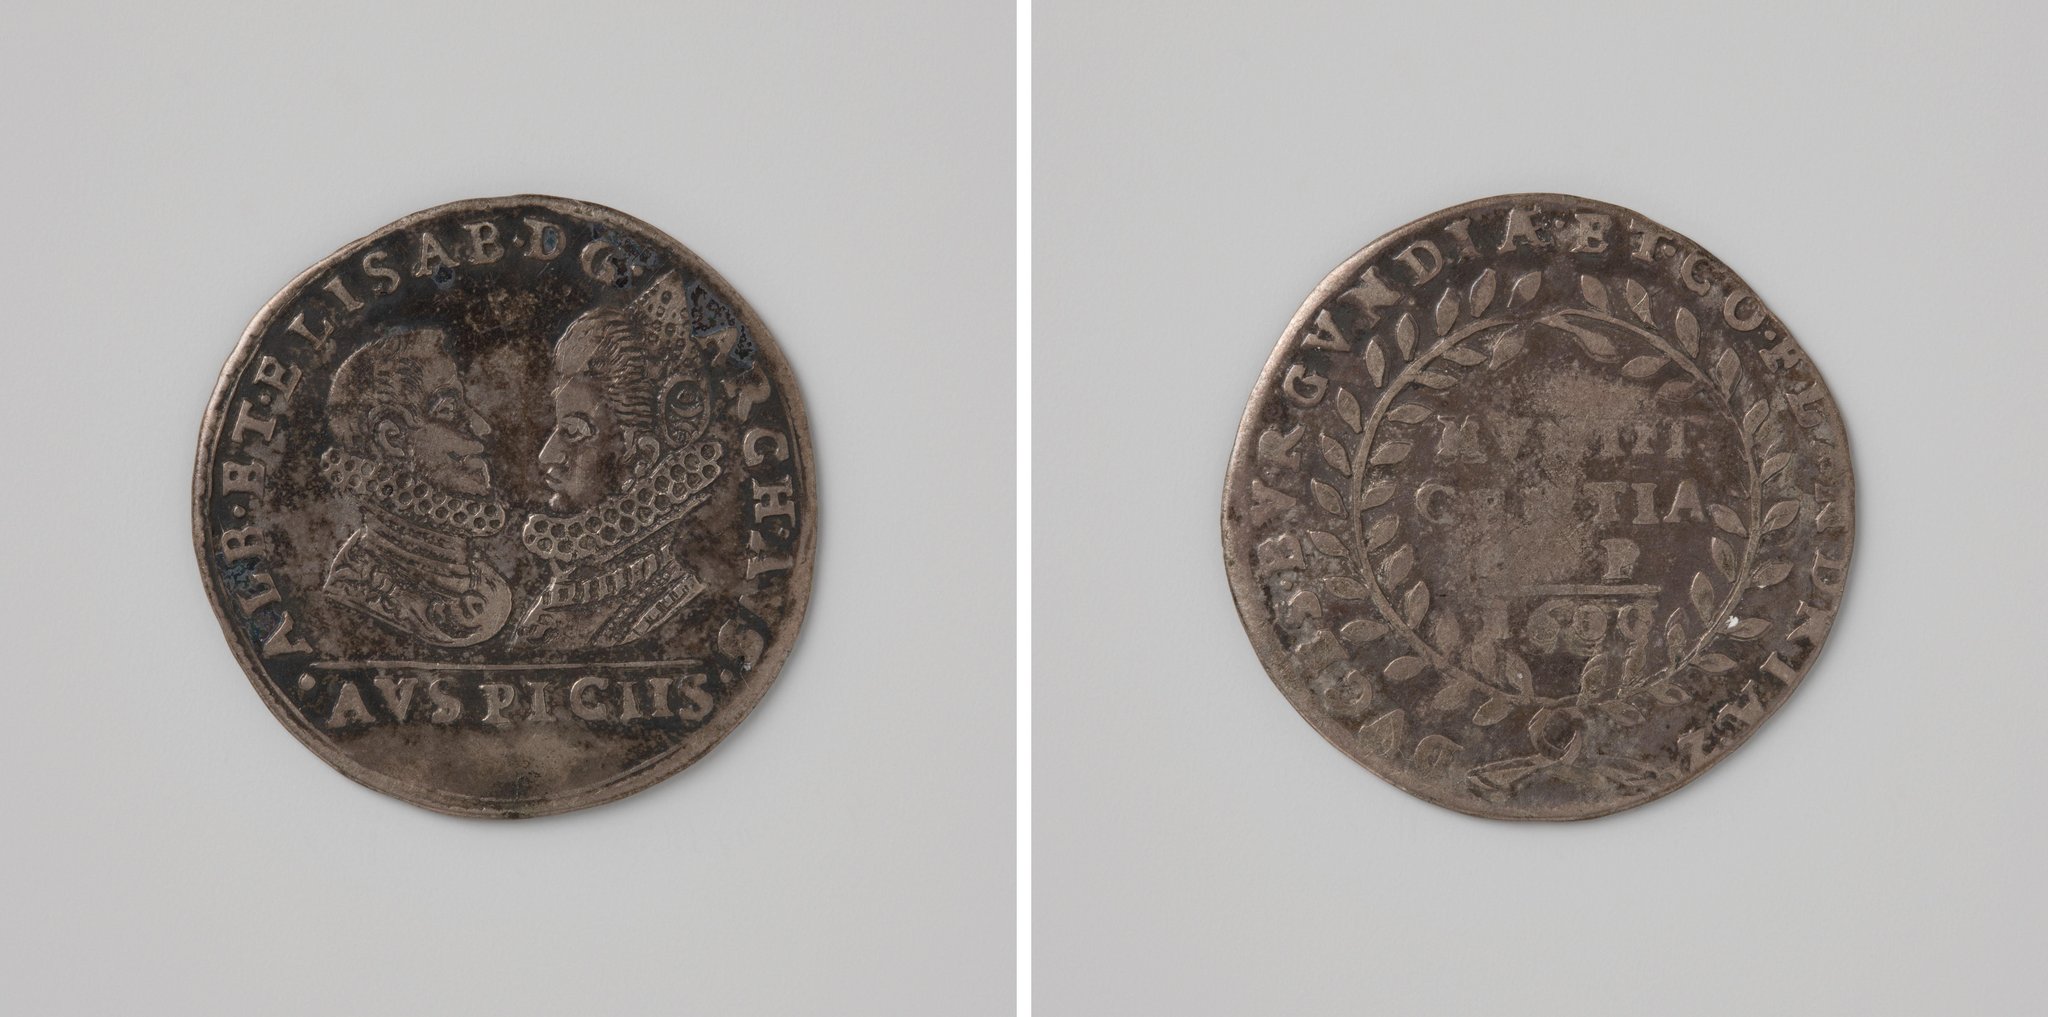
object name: strooipenning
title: Inkomst van Albertus en Isabella in Vlaanderen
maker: Anonymous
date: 1600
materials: silver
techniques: striking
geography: southern netherlands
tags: infante van spanje isabella clara eugenia, brussels, albrecht aartshertog van oostenrijk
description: Zilveren penning. Voorzijde: borststukken man en vrouw, naar elkaar gekeerd binnen omschrift. Keerzijde: opschrift binnen lauwerkrans en omschrift